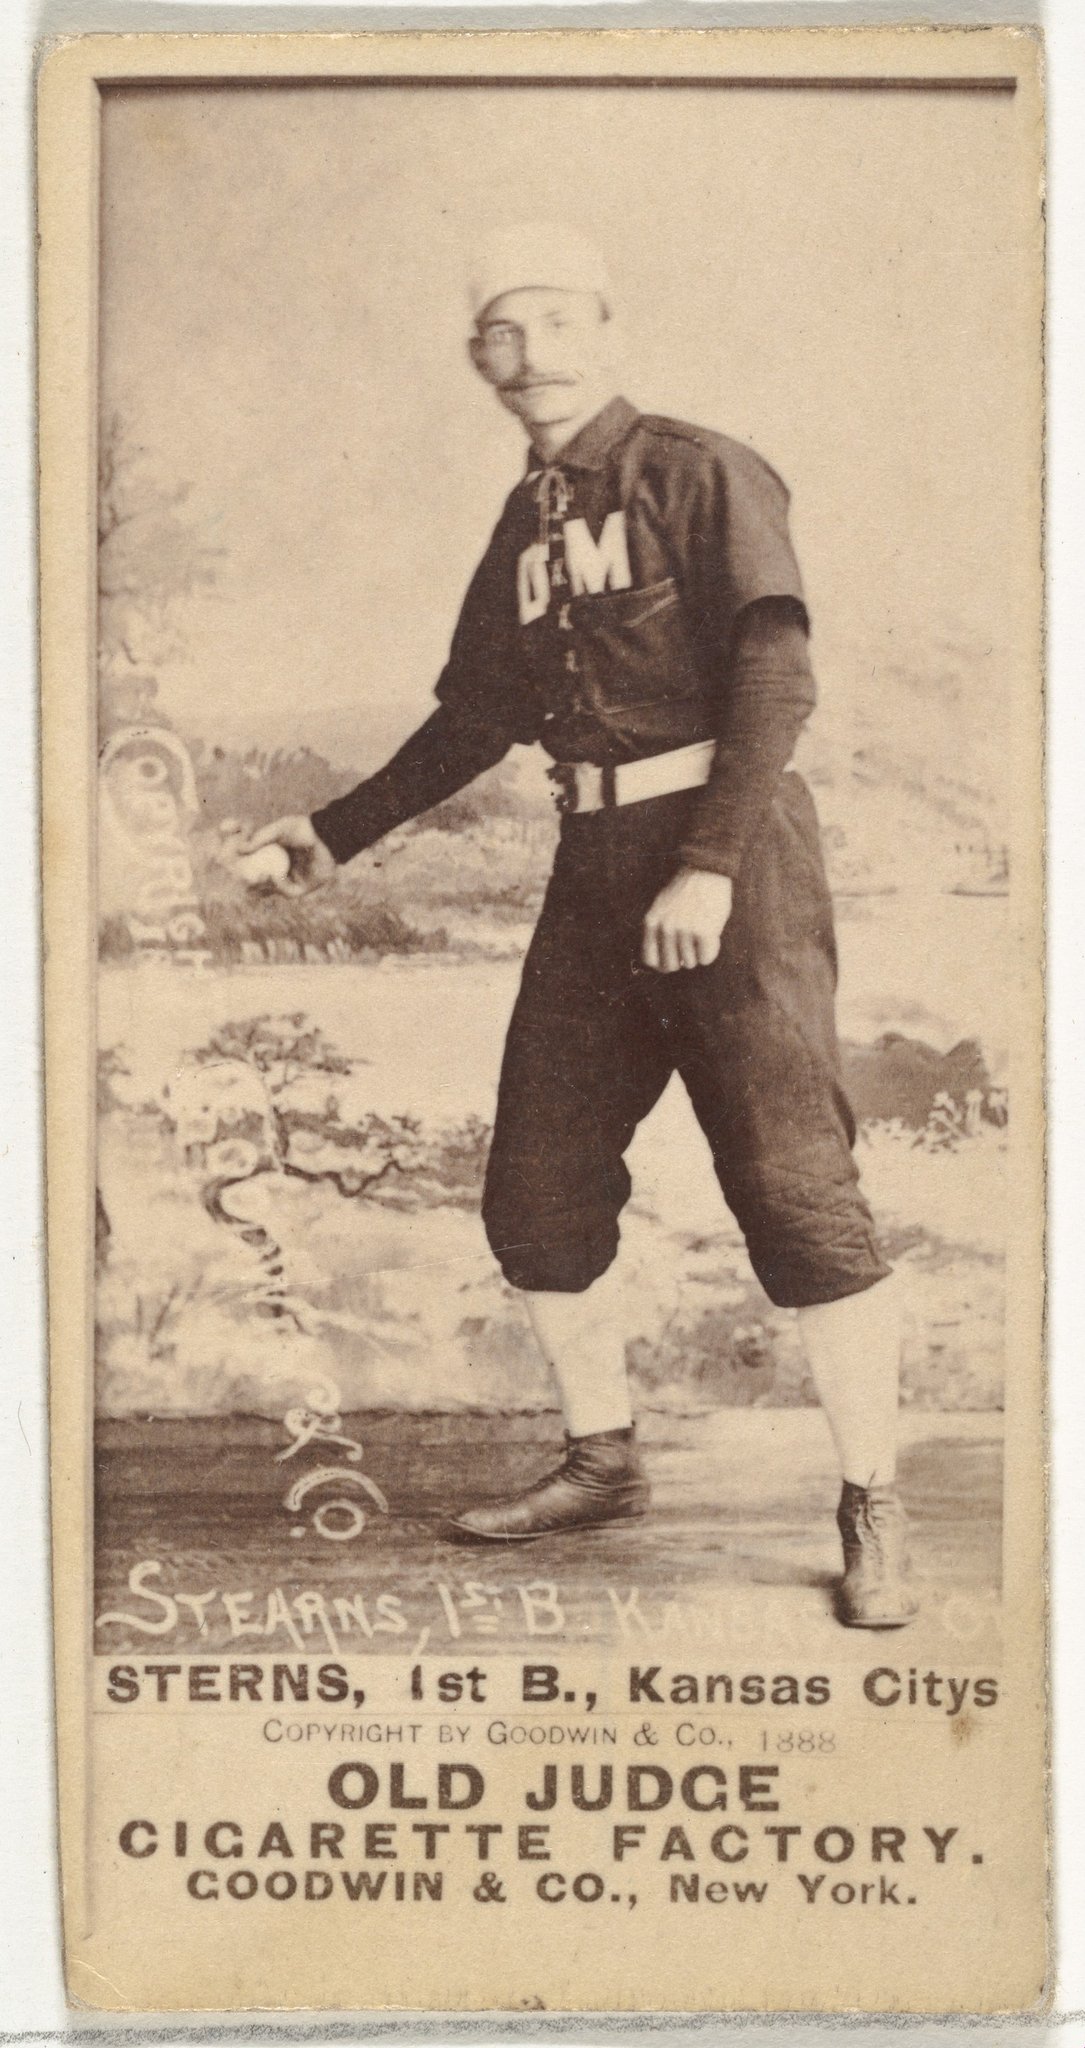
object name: baseball card, photograph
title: Daniel Eckford "Ecky" Stearns, 1st Base, Kansas City Cowboys, from the Old Judge series (N172) for Old Judge Cigarettes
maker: goodwin & company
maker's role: publisher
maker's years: 1850-1950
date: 1888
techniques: albumen silver print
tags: men,portraits,baseball,athletes